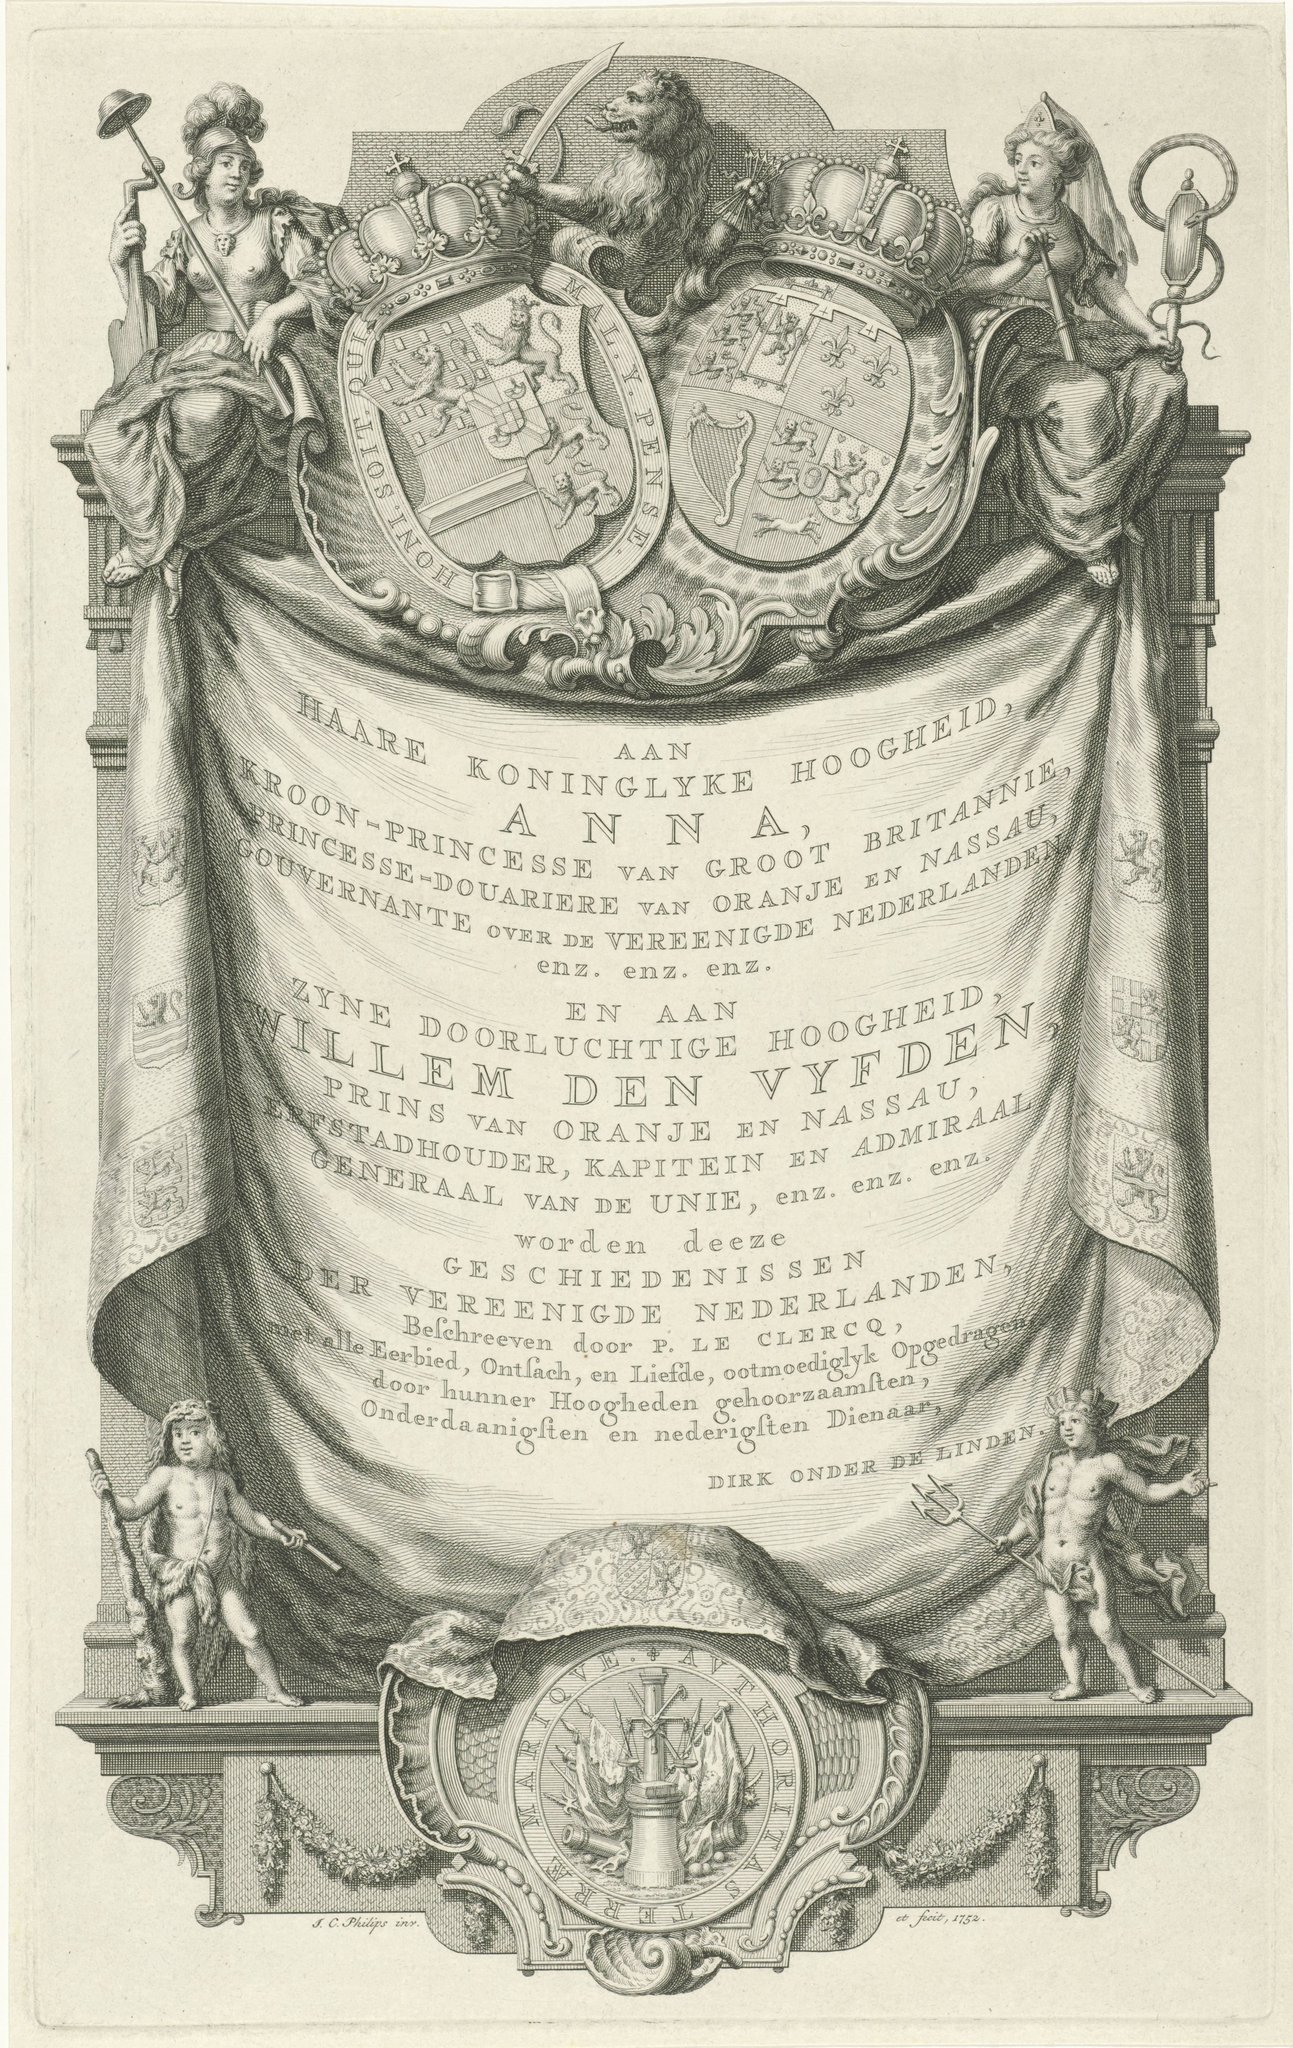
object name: print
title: Titelpagina voor: P. Le Clercq, Geschiedenissen der vereenigde Nederlanden, 1752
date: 1752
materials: paper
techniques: engraving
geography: amsterdam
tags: the hague, william v (prince of orange), anna van hannover, (story of) neptune (poseidon), (story of) hercules (heracles), prudence, 'prudentia'; 'prudenza' (ripa) ~ one of the four cardinal virtues, freedom, liberty; 'libertà' (ripa), symbols of particular nations, states, districts, etc.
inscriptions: collector's mark: Lugt 2233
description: Ornamentele omlijsting met een doek waarop de titel in het Nederlands. De omlijsting is bekroond met de wapenschilden van Anna van Hannover, prinses van Oranje-Nassau, haar zoon Willem V, prins van Oranje-Nassau, en de Nederlandse Leeuw. Op de hoeken de Vrijheid (Libertas) en Voorzichtigheid (Prudentia). Onderaan een Hercules en Neptunus, als kinderen.